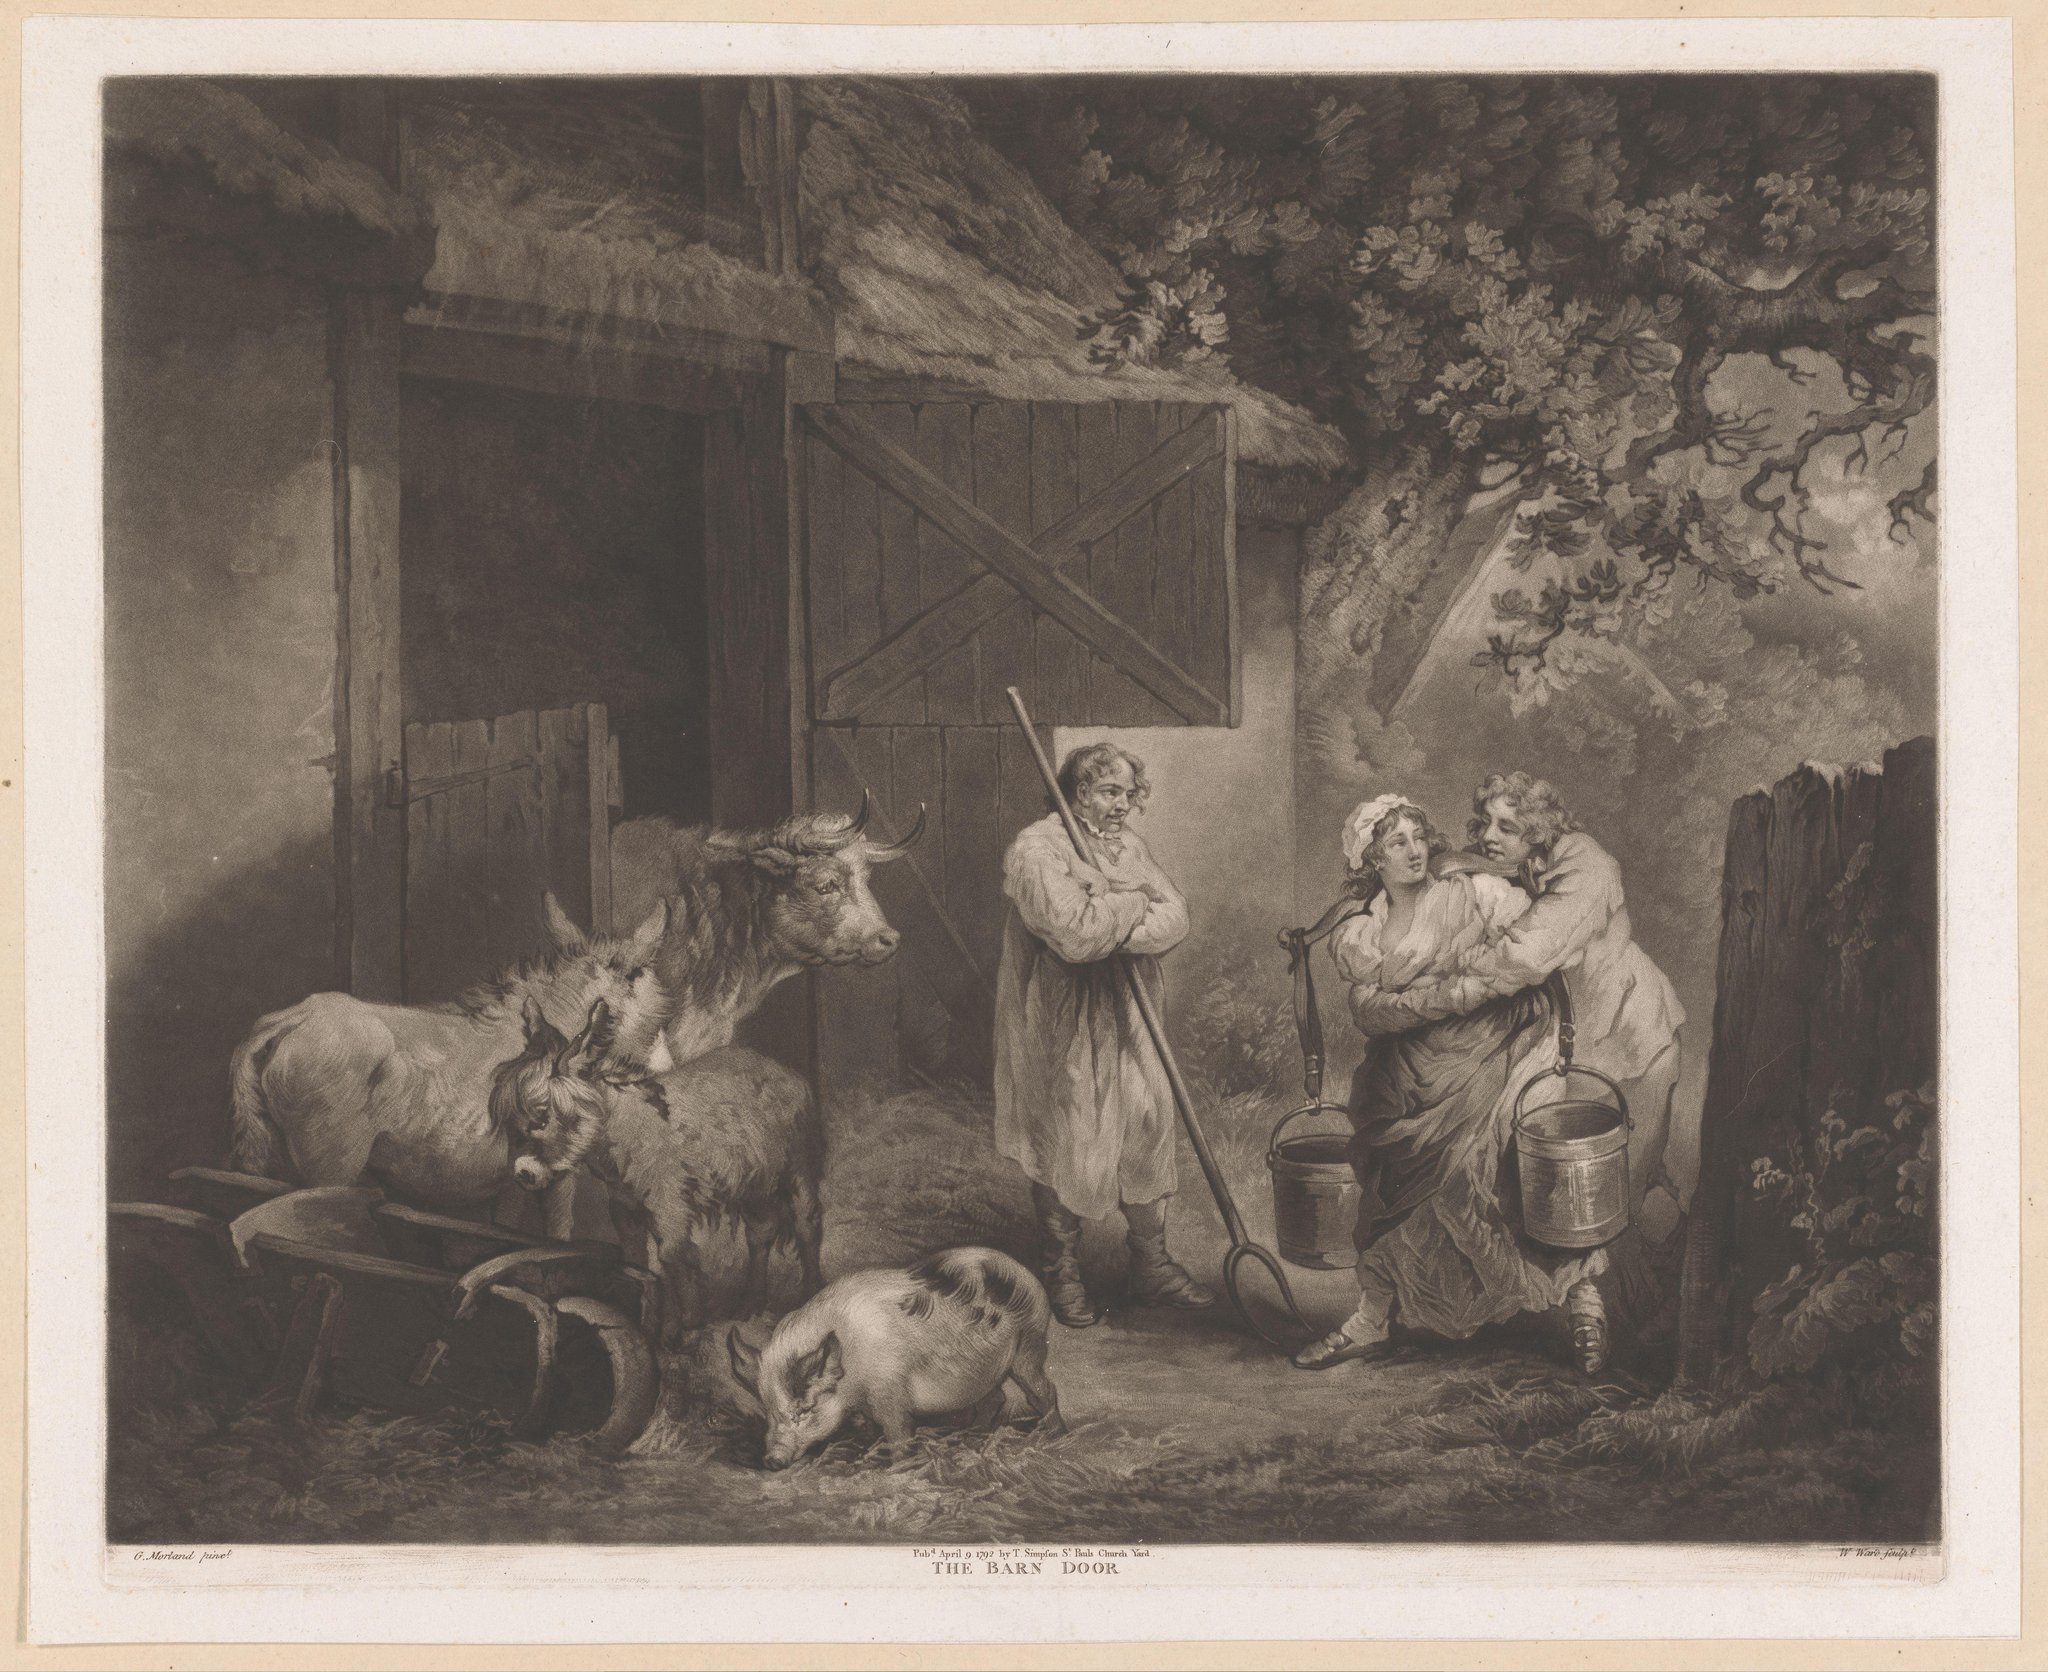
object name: print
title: The Barn Door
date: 1792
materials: paper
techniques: mezzotint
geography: london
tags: barn, cattle, farmers, milkmaid, lovers; courting, flirting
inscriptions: collector's mark: Lugt 2228, number: ‘No. 2405’